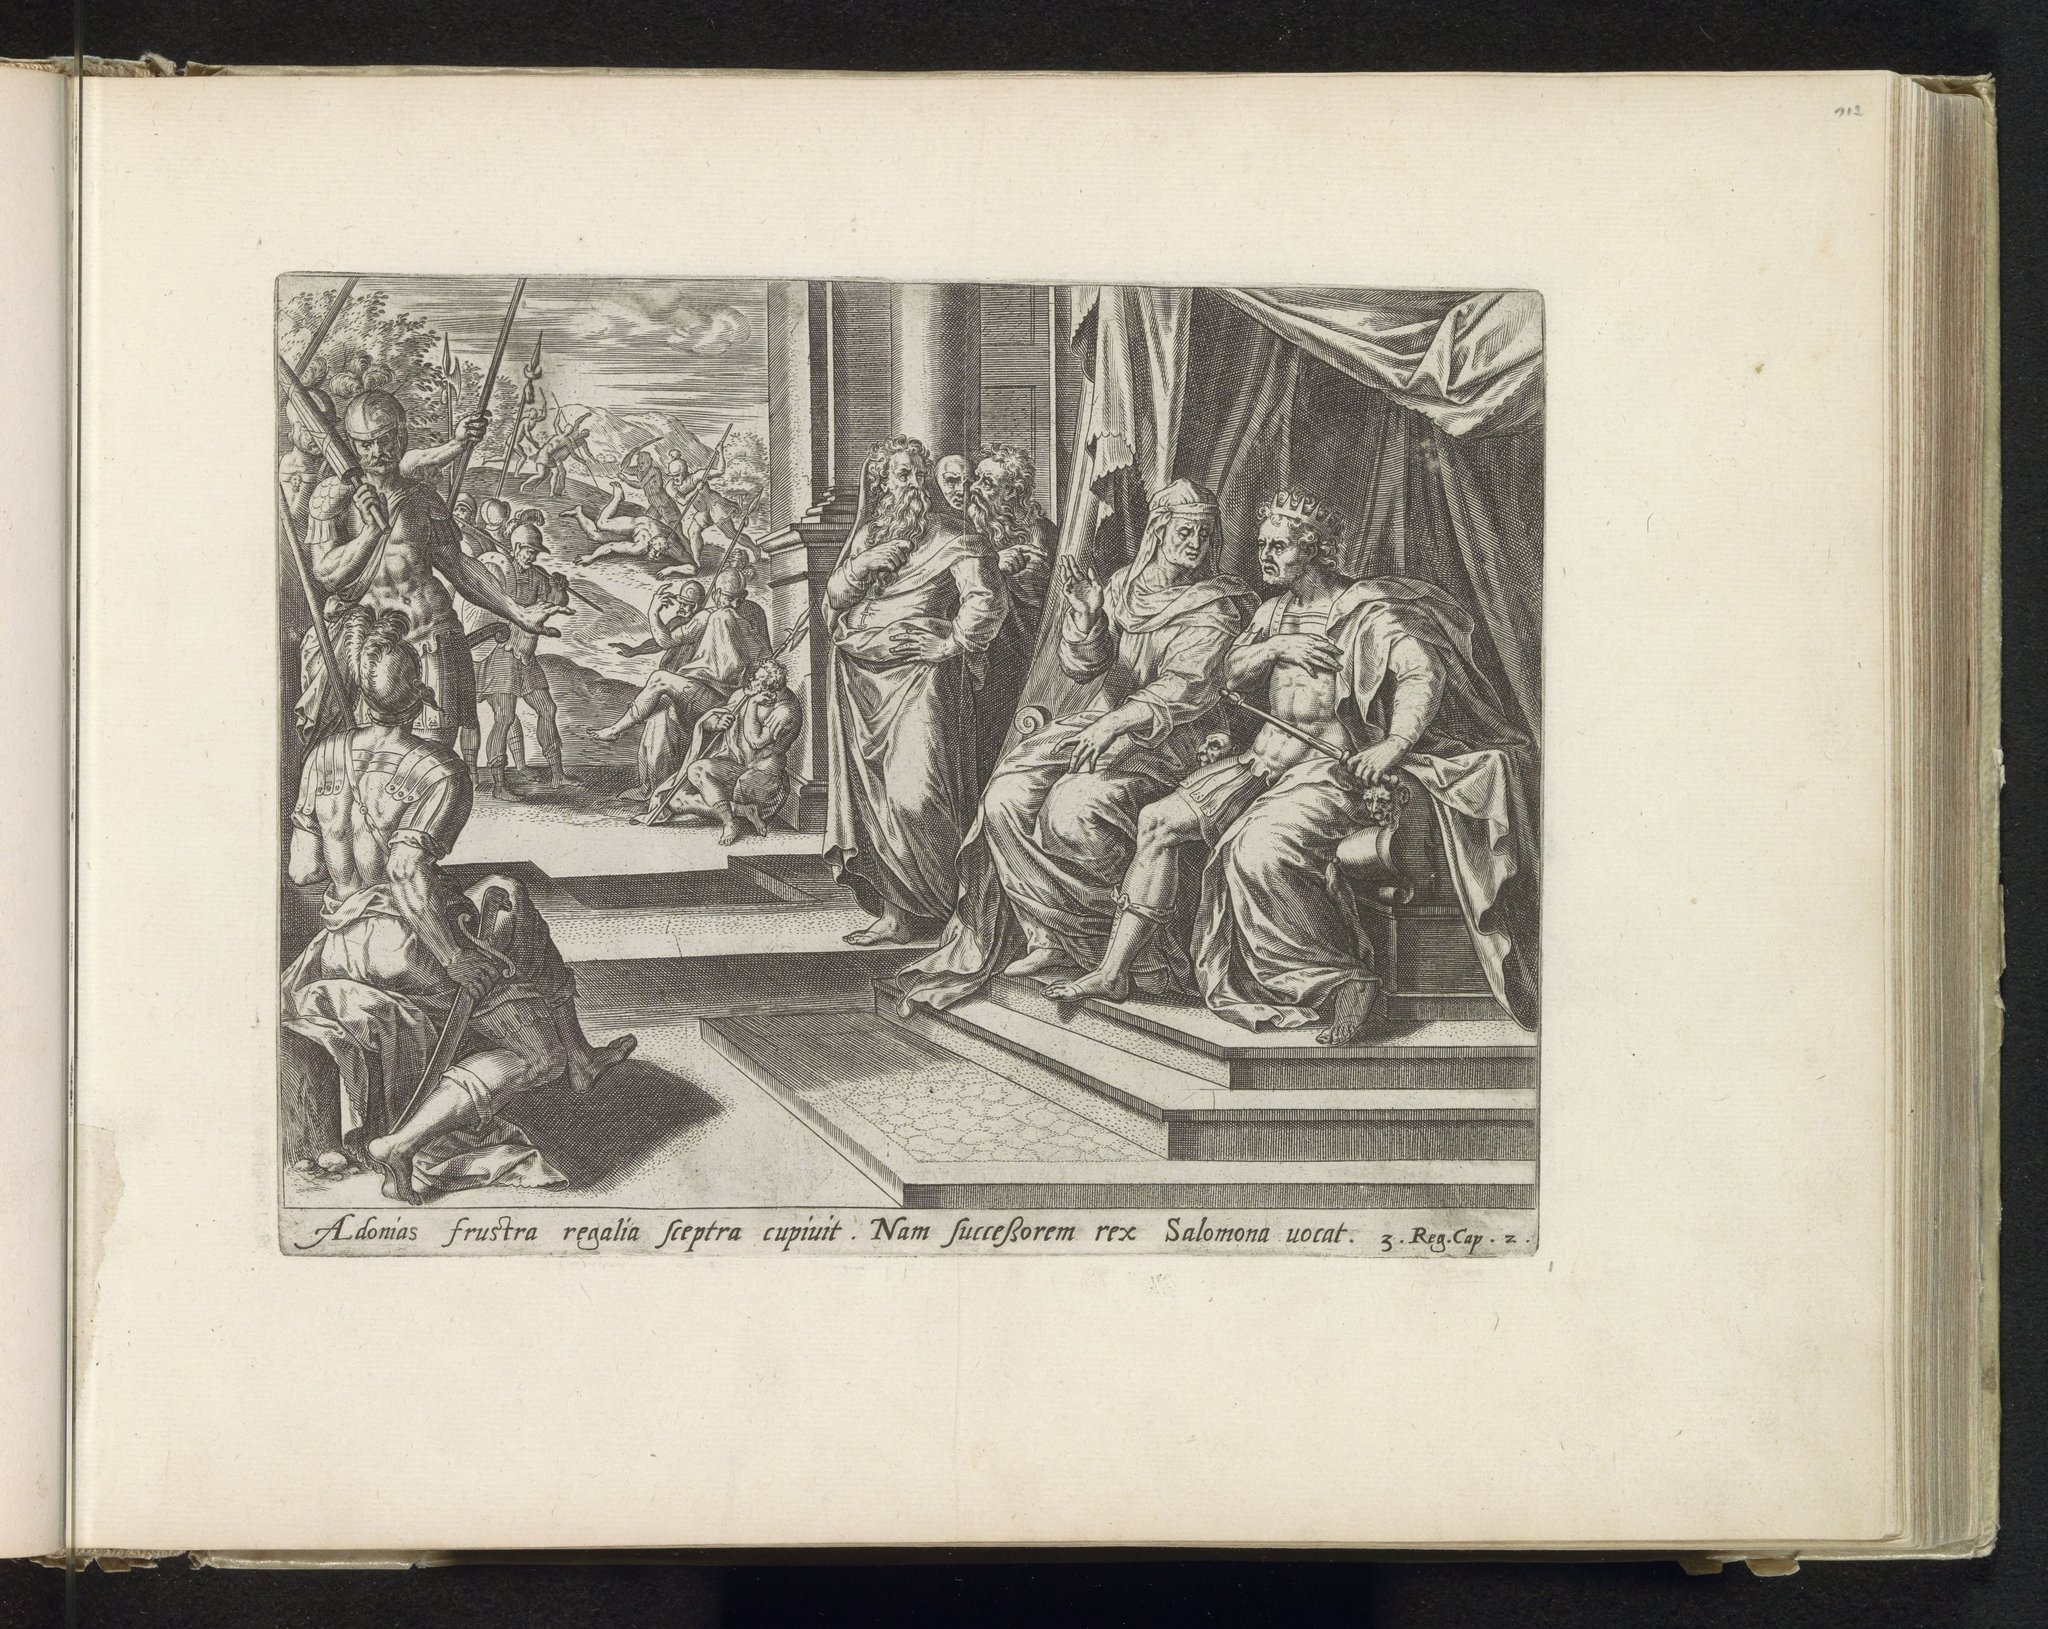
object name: print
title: Thesaurus sacrarum historiaru[m] veteris testame[n]ti, elega[n]tissimis imaginibus expressu[m] excelle[n]tissimoru[m] in hac arte viroru[m] opera: nu[n]c primu[m] in luce[m] editus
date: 1585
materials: paper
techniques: engraving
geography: antwerp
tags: bathsheba brings adoniah's request to solomon, adoniah is killed by benaiah, solomon and bathsheba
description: Batseba zit aan de rechterhand van haar zoon, koning Salomo, en brengt de vraag van Salomo's broer Adonia aan hem over. Zij vraagt voor Adonia om de hand van Abisag. Salomo wordt woedend en geeft opdracht Adonia te doden. Op de achtergrond wordt Adonia met een lans doorstoken. Onder de voorstelling een verwijzing in het Latijn naar de Bijbeltekst in 1 Kon. 2. Deze prent maakt deel uit van een album.